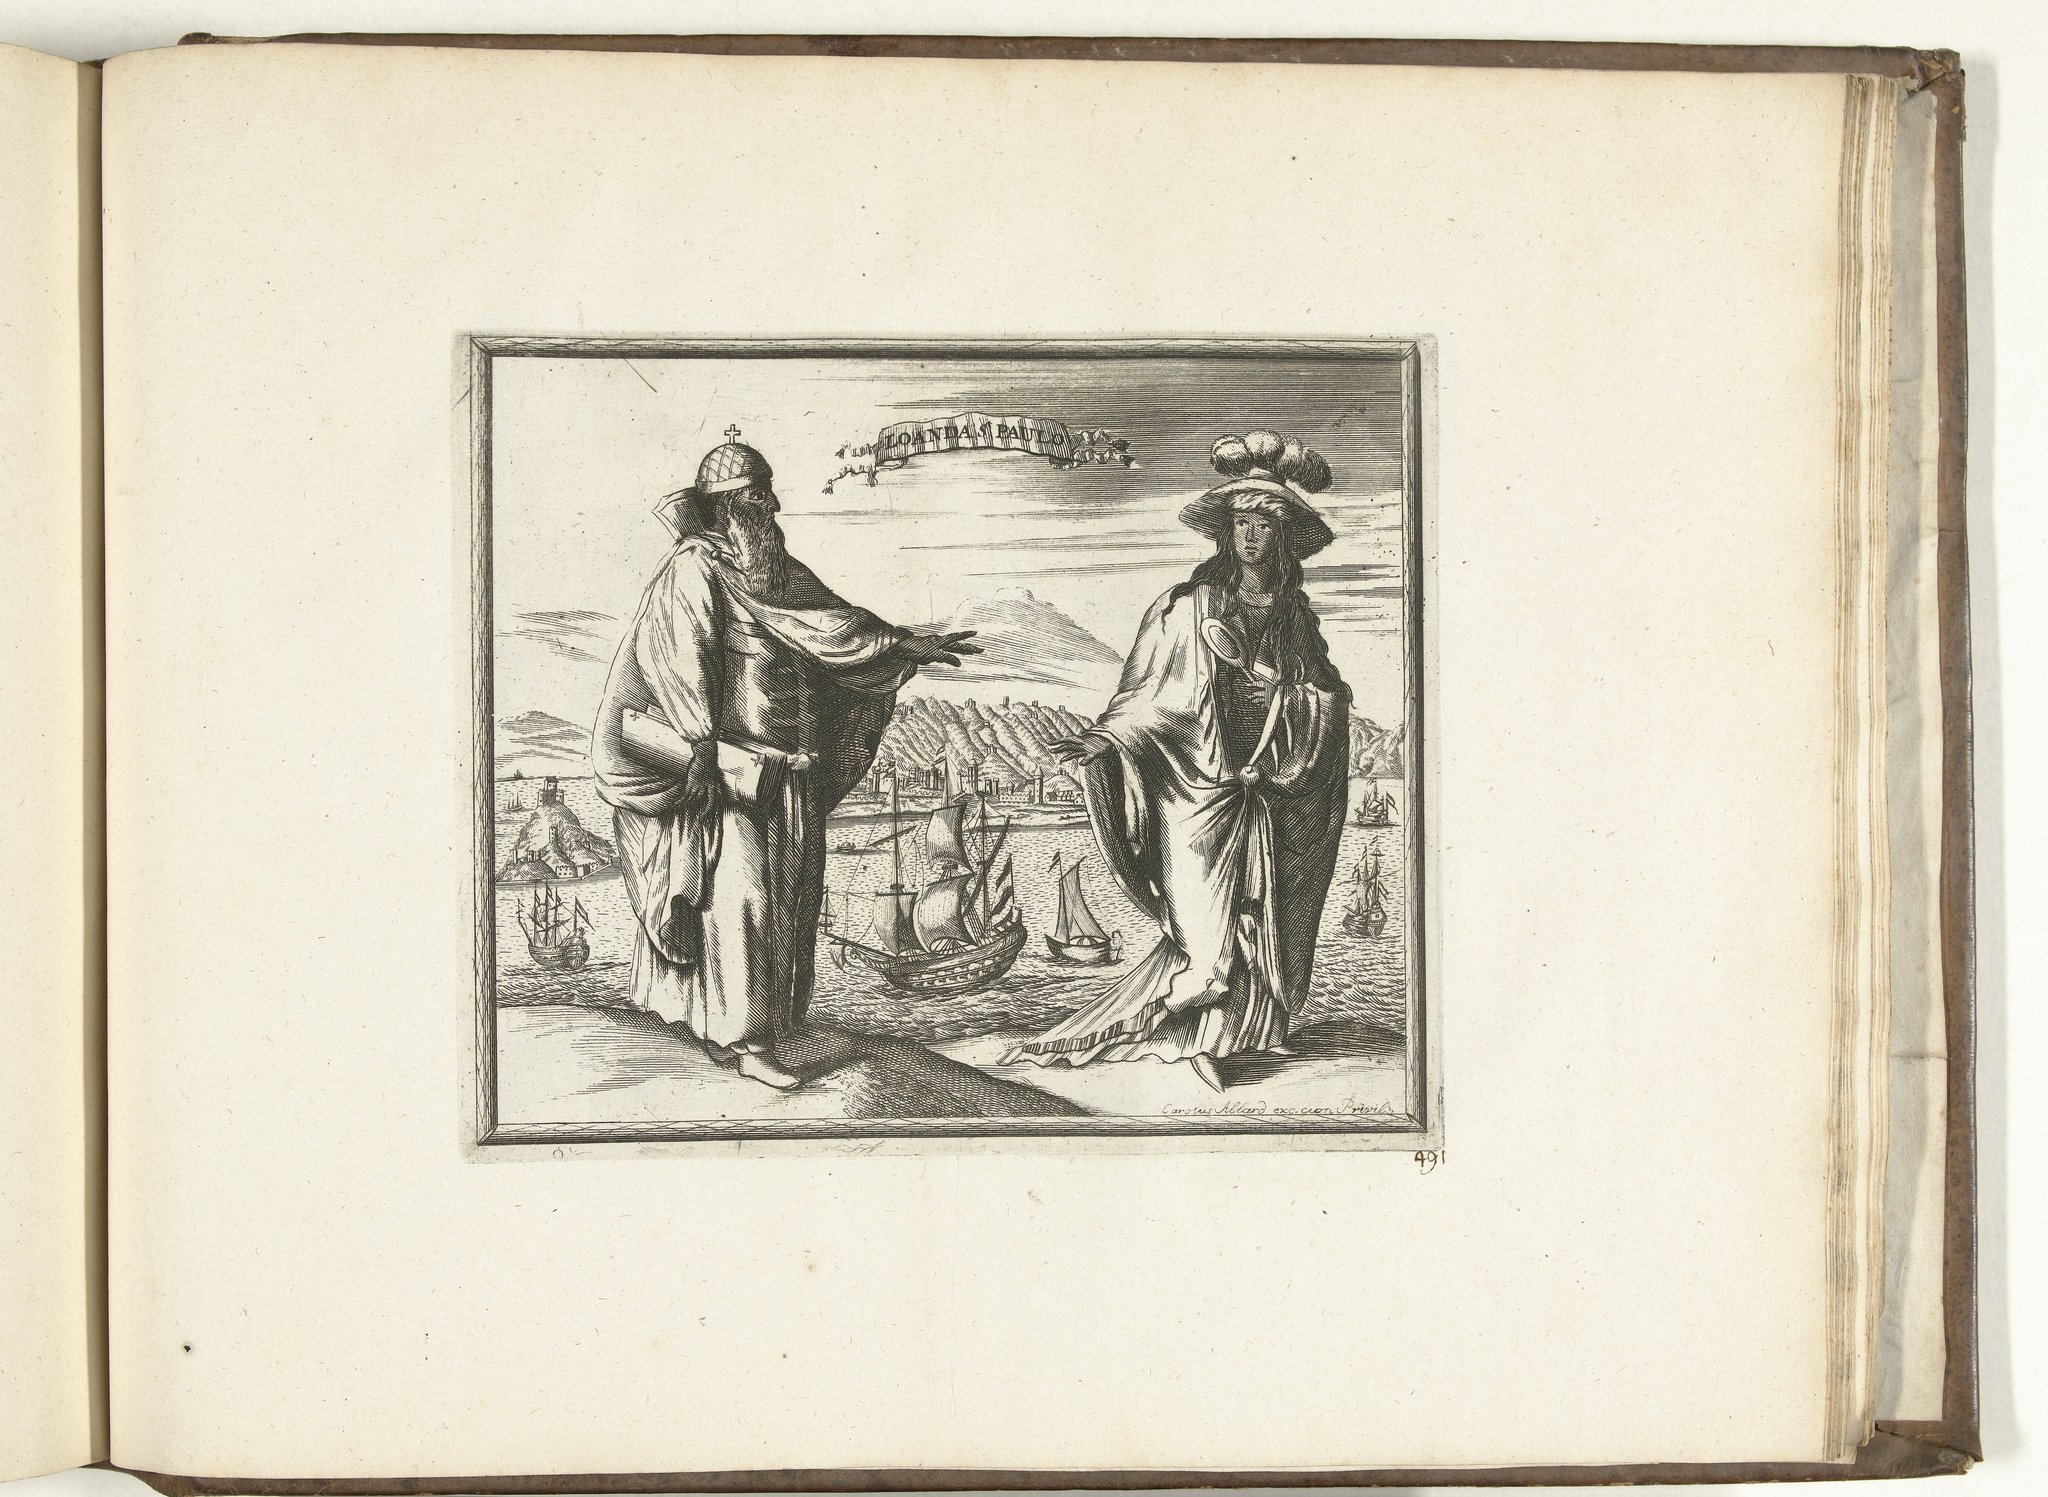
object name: costume print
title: Loanda St. Paulo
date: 1726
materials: paper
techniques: engraving, etching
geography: amsterdam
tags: africans, folk costume, regional costume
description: Man en vrouw van Luanda in Angola, gekleed in lokaal kostuum, op de achtergrond de stad. Plaat nr. 491 in deel XX van het prentwerk: Les Forces de l'Europe, Asie, Afrique et Amerique ... Comme aussi les Cartes des Côtes de France et d'Espagne uit 1726, dit tweede deel met 271 met de hand genummerde platen van vermaarde sterke steden en vestingen in het kader van de Spaanse Successieoorlog 1701-1713. Voor het merendeel zijn deze platen gekopieerd naar de anonieme Franse platen van vermaarde sterke steden en vestingen: in Les forces de l'Europe en in: Le theatre de la guerre, dans les Pays-Bas, beide oorspronkelijk uitgegeven door Nicolas de Fer te Parijs (1693-1697) in het kader van de Negenjarige Oorlog.